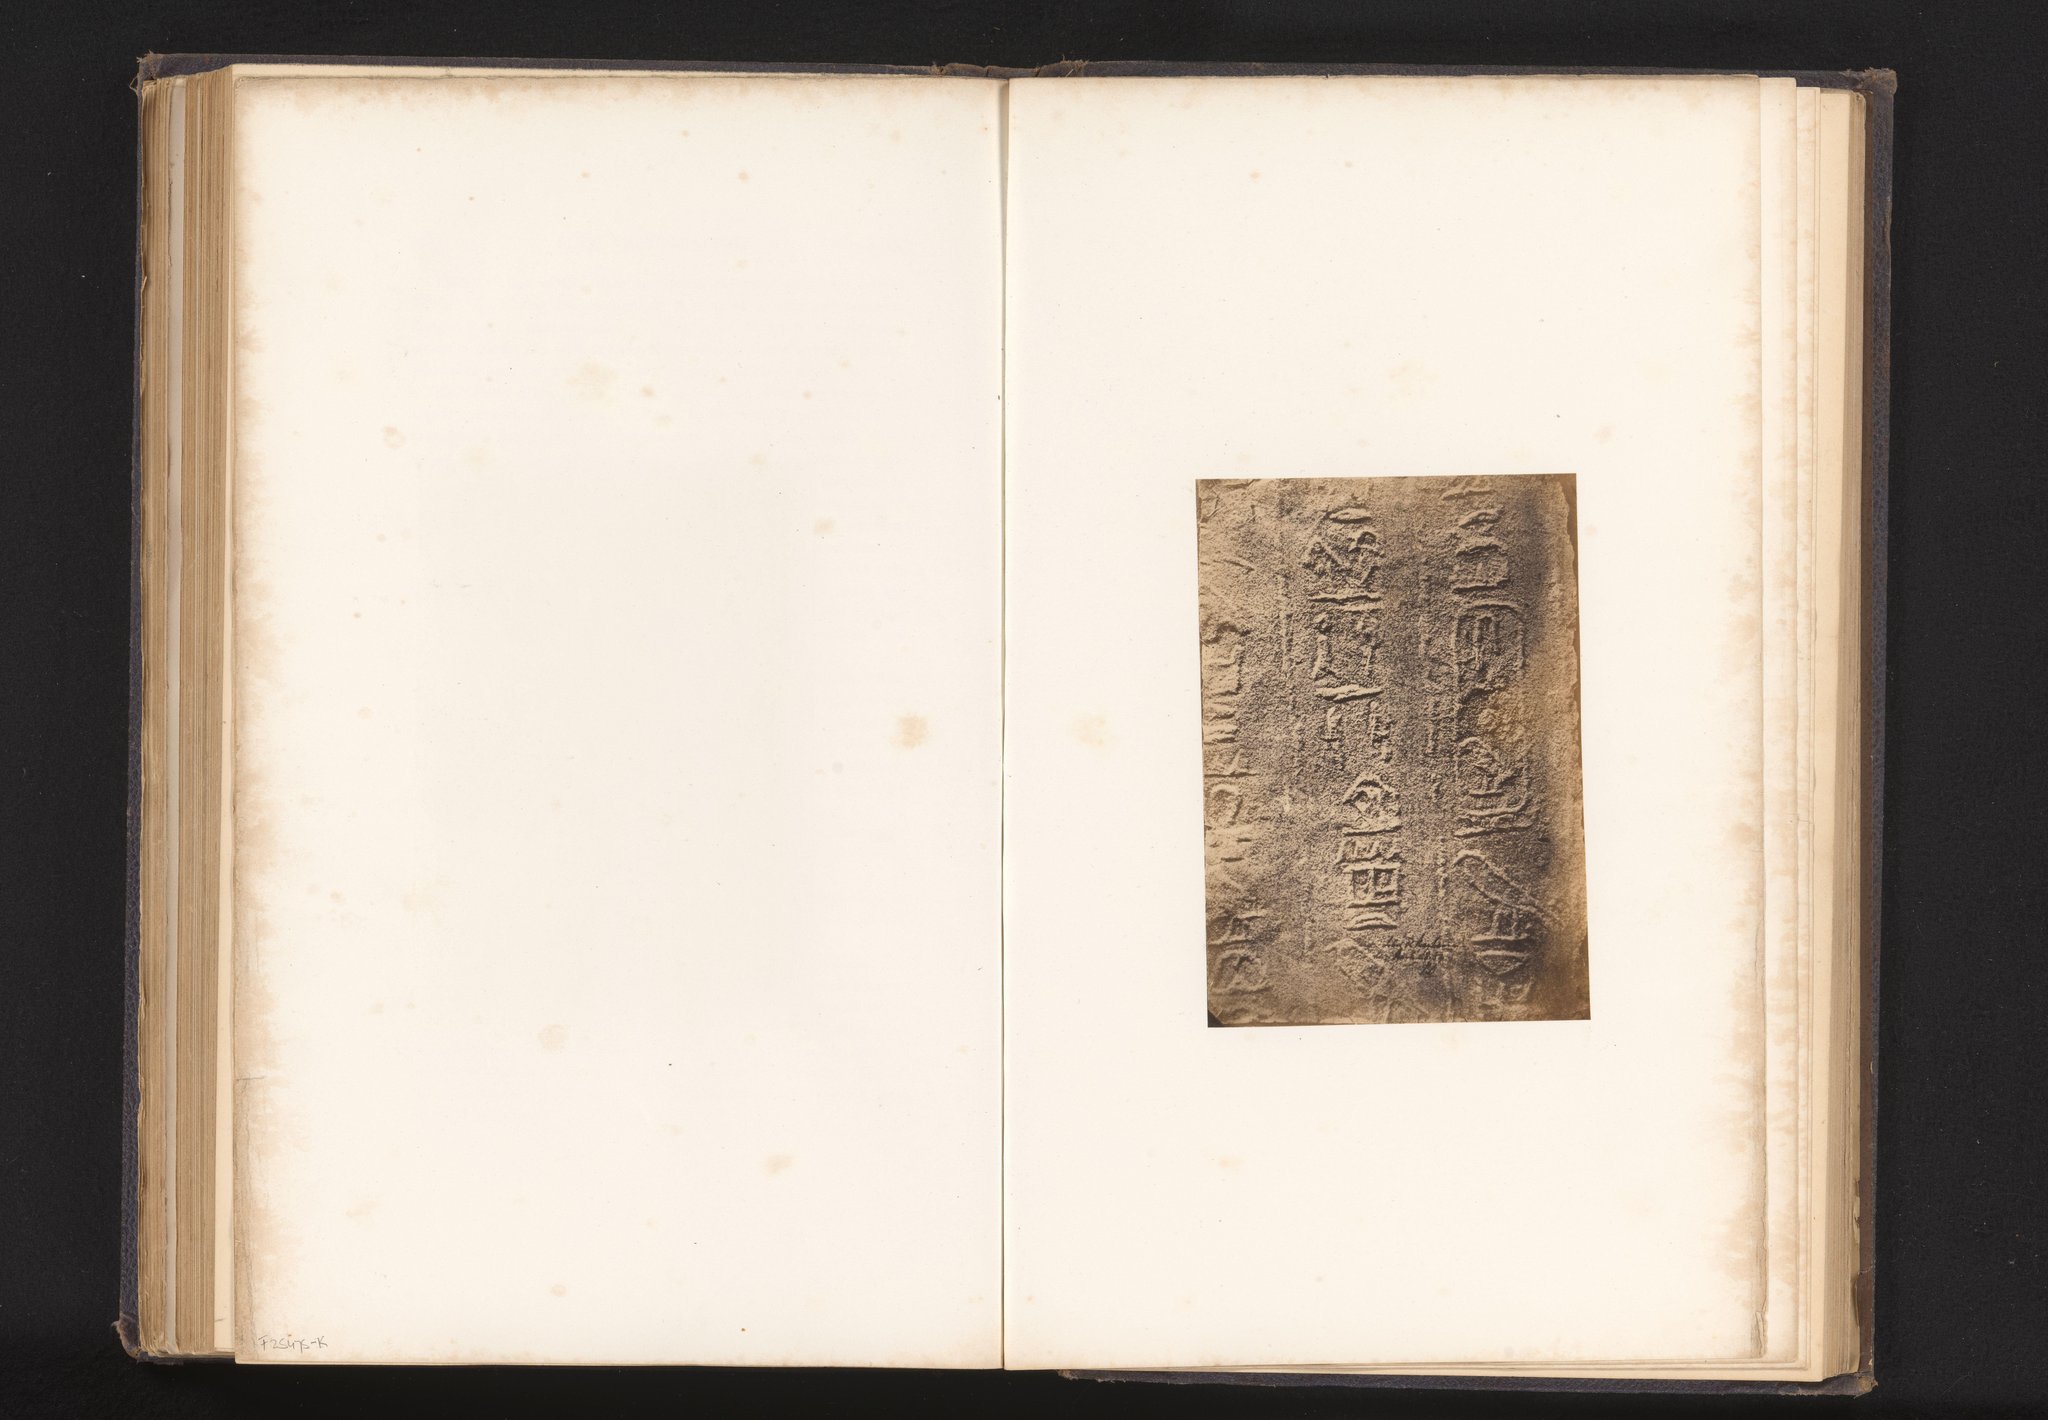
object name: page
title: Gipsen afgietsel van een tablet met hiërogliefen uit Wadi Maghareh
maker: a.j. brown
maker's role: fotograaf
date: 1857-1862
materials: paper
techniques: albumen print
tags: egyptian hieroglyphs